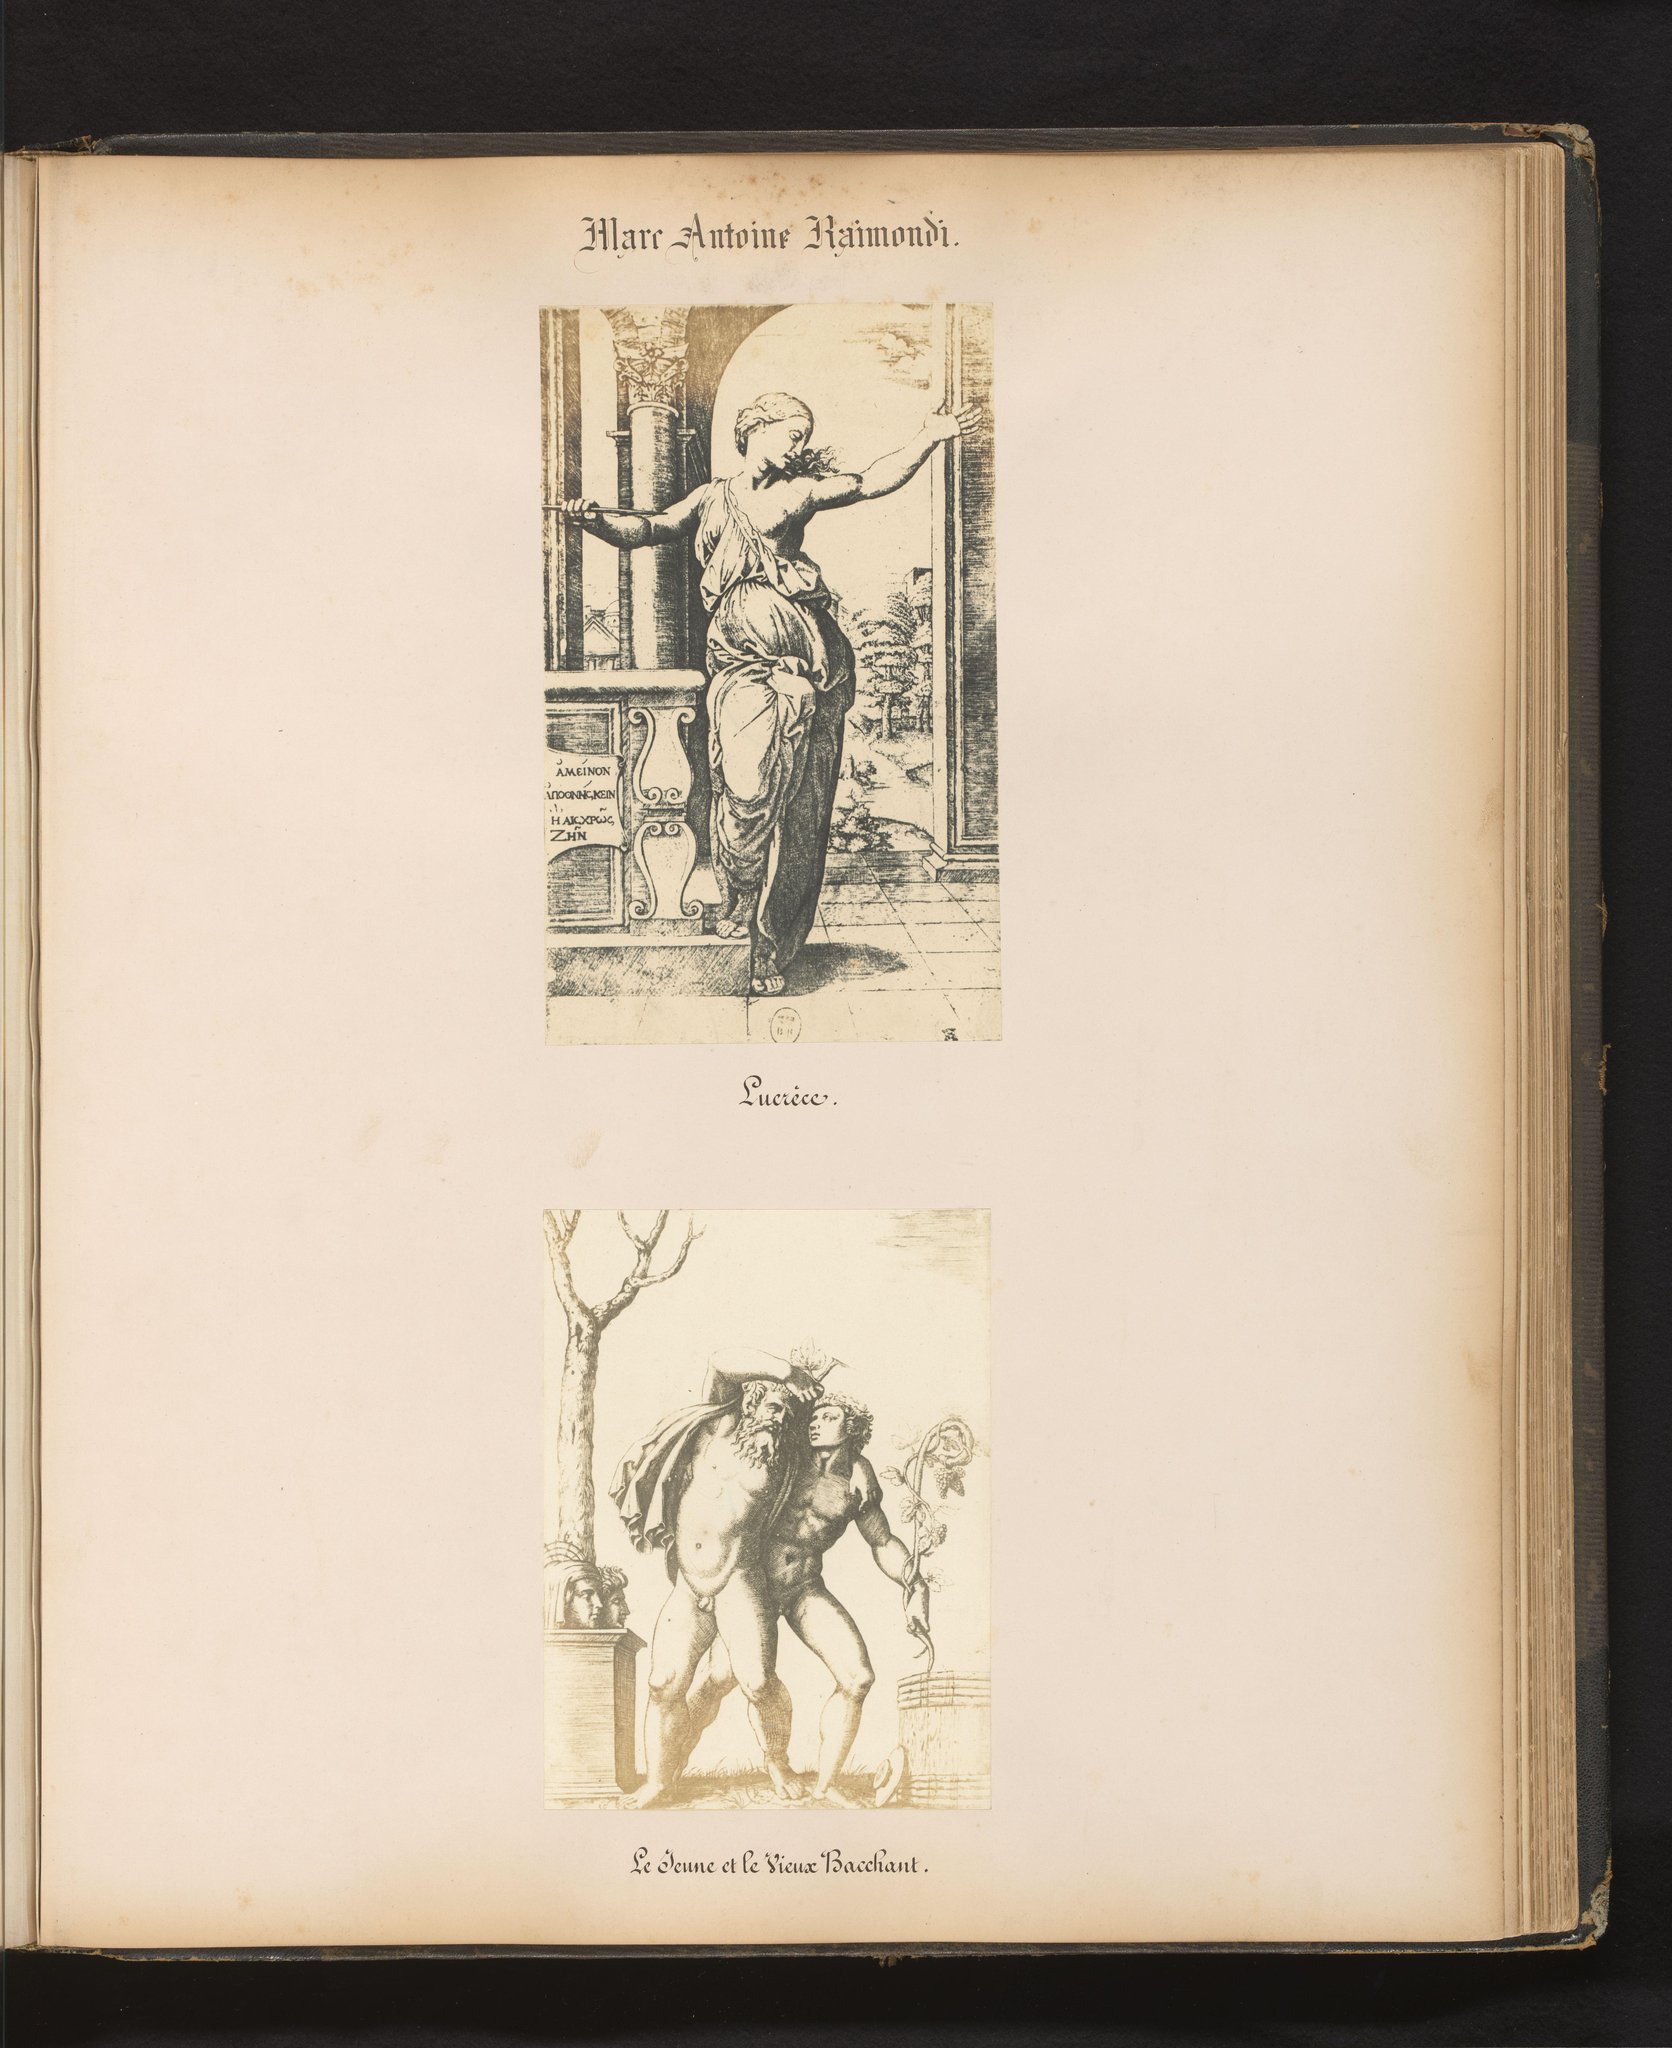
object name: page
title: Le Jeune et le Vieux Bacchant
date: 1848-1853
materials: photographic support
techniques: salted paper print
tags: youth, adolescent, male bacchant(es), old man